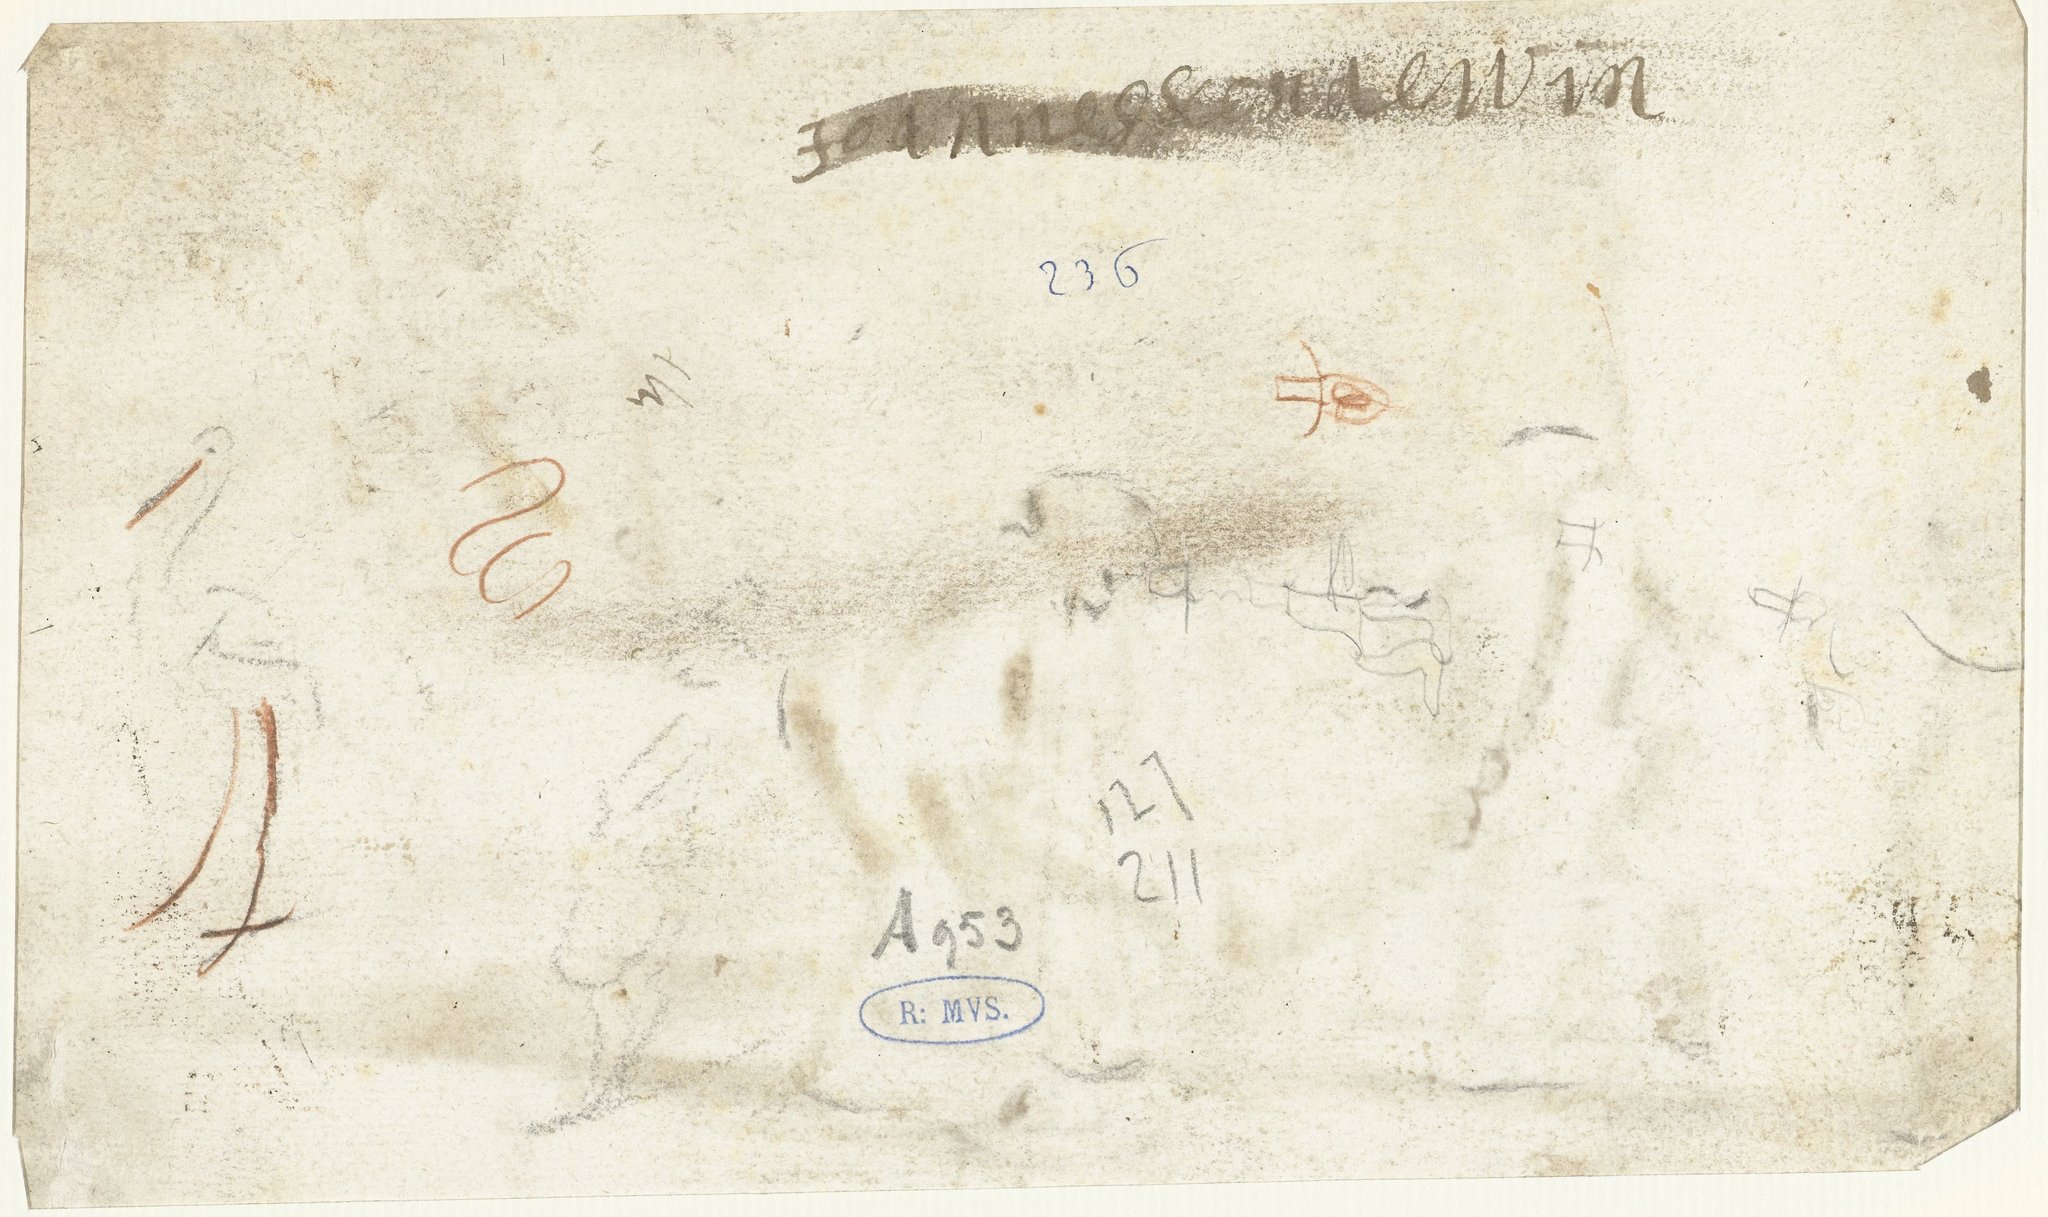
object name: drawing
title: Studieblad met kindertekeningen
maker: harmen ter borch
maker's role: draughtsman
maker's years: 1638-1677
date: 1649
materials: chalk, paper, pencil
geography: zwolle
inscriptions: annotation: ‘Joannesken dewin’